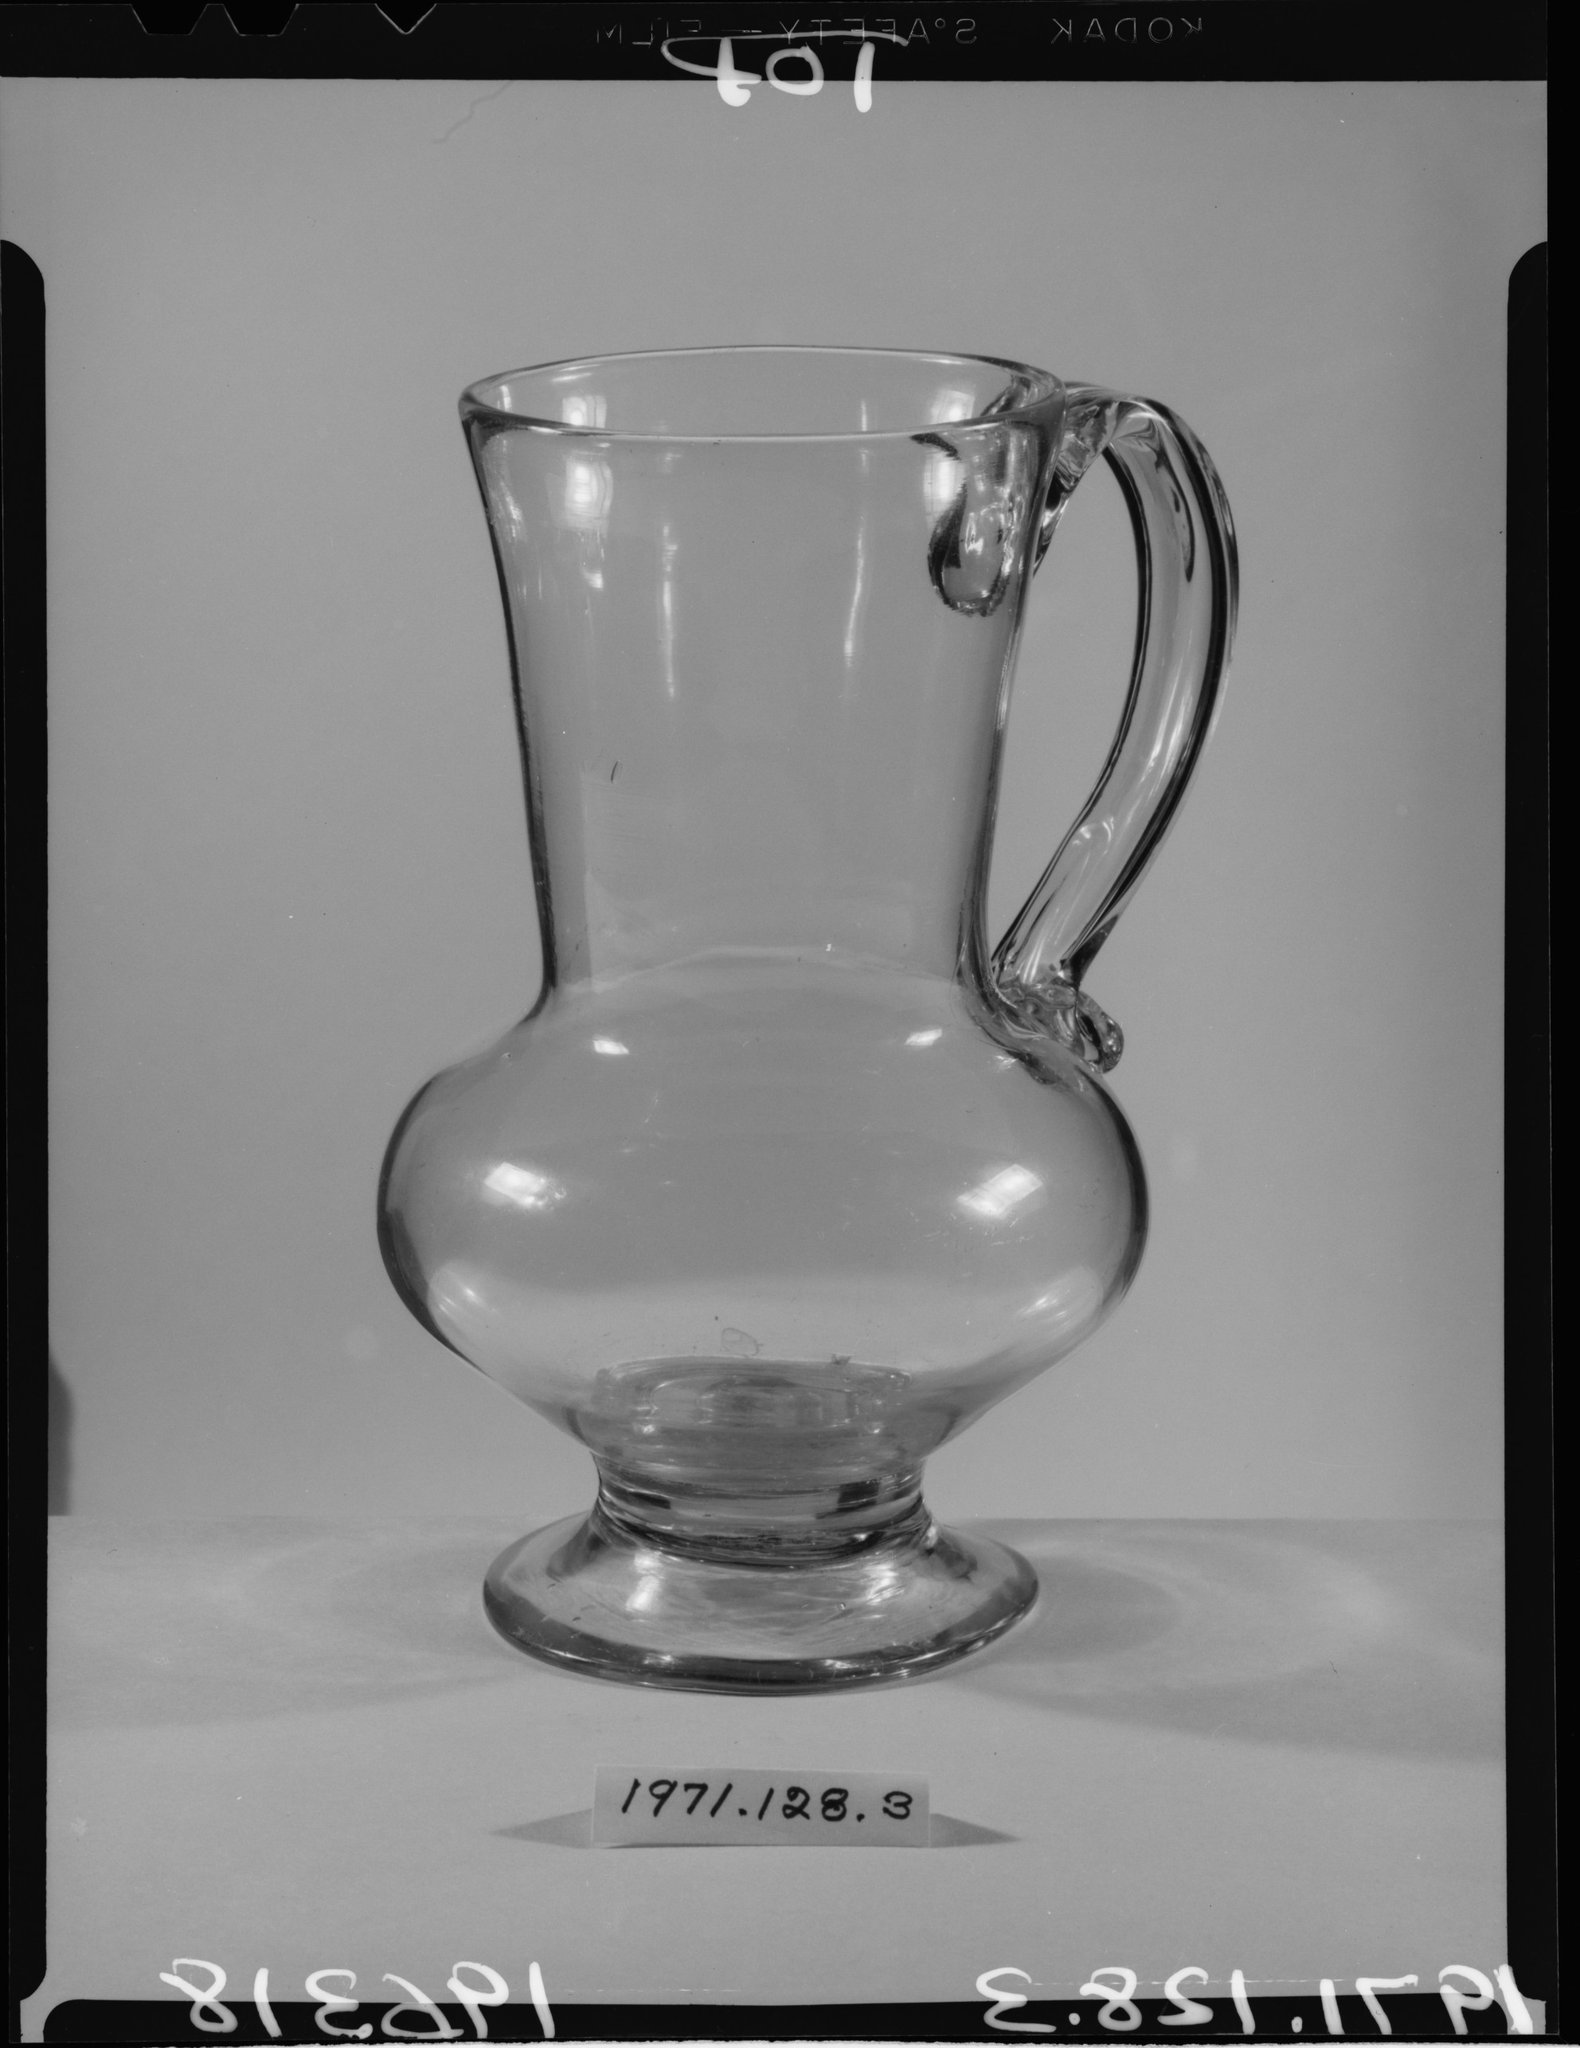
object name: mug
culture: american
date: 1770-1800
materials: glass, lead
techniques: glassblowing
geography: united states